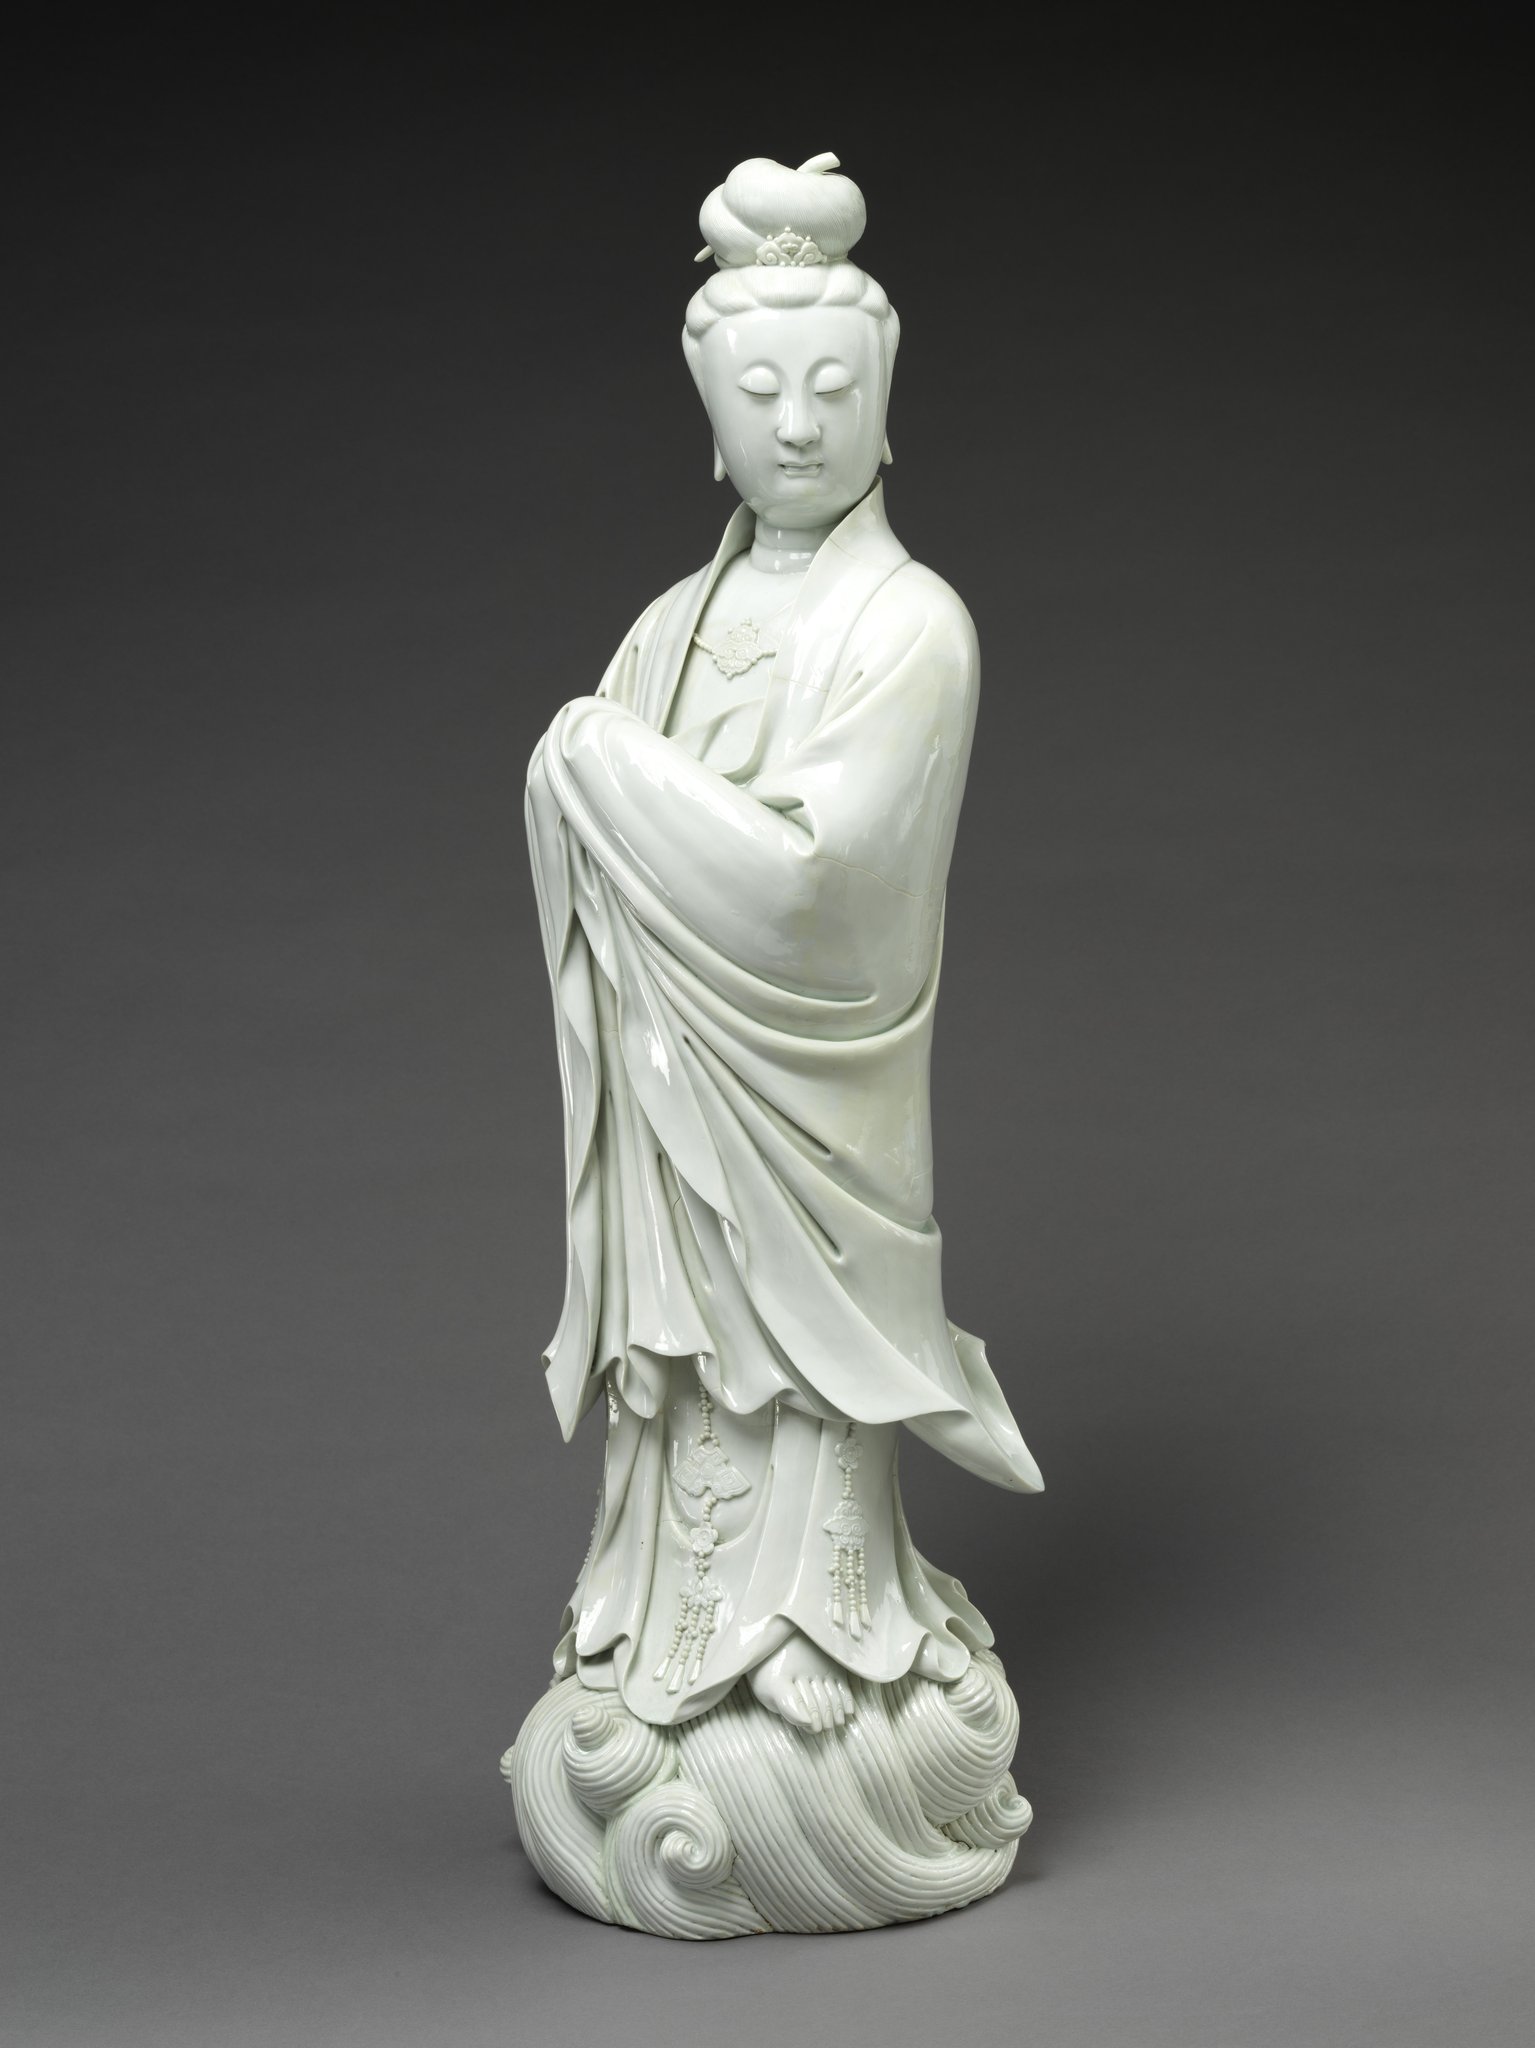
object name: figure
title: White-Robed Guanyin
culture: chinese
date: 1701-1800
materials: glaze, porcelain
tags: buddhism,bodhisattvas